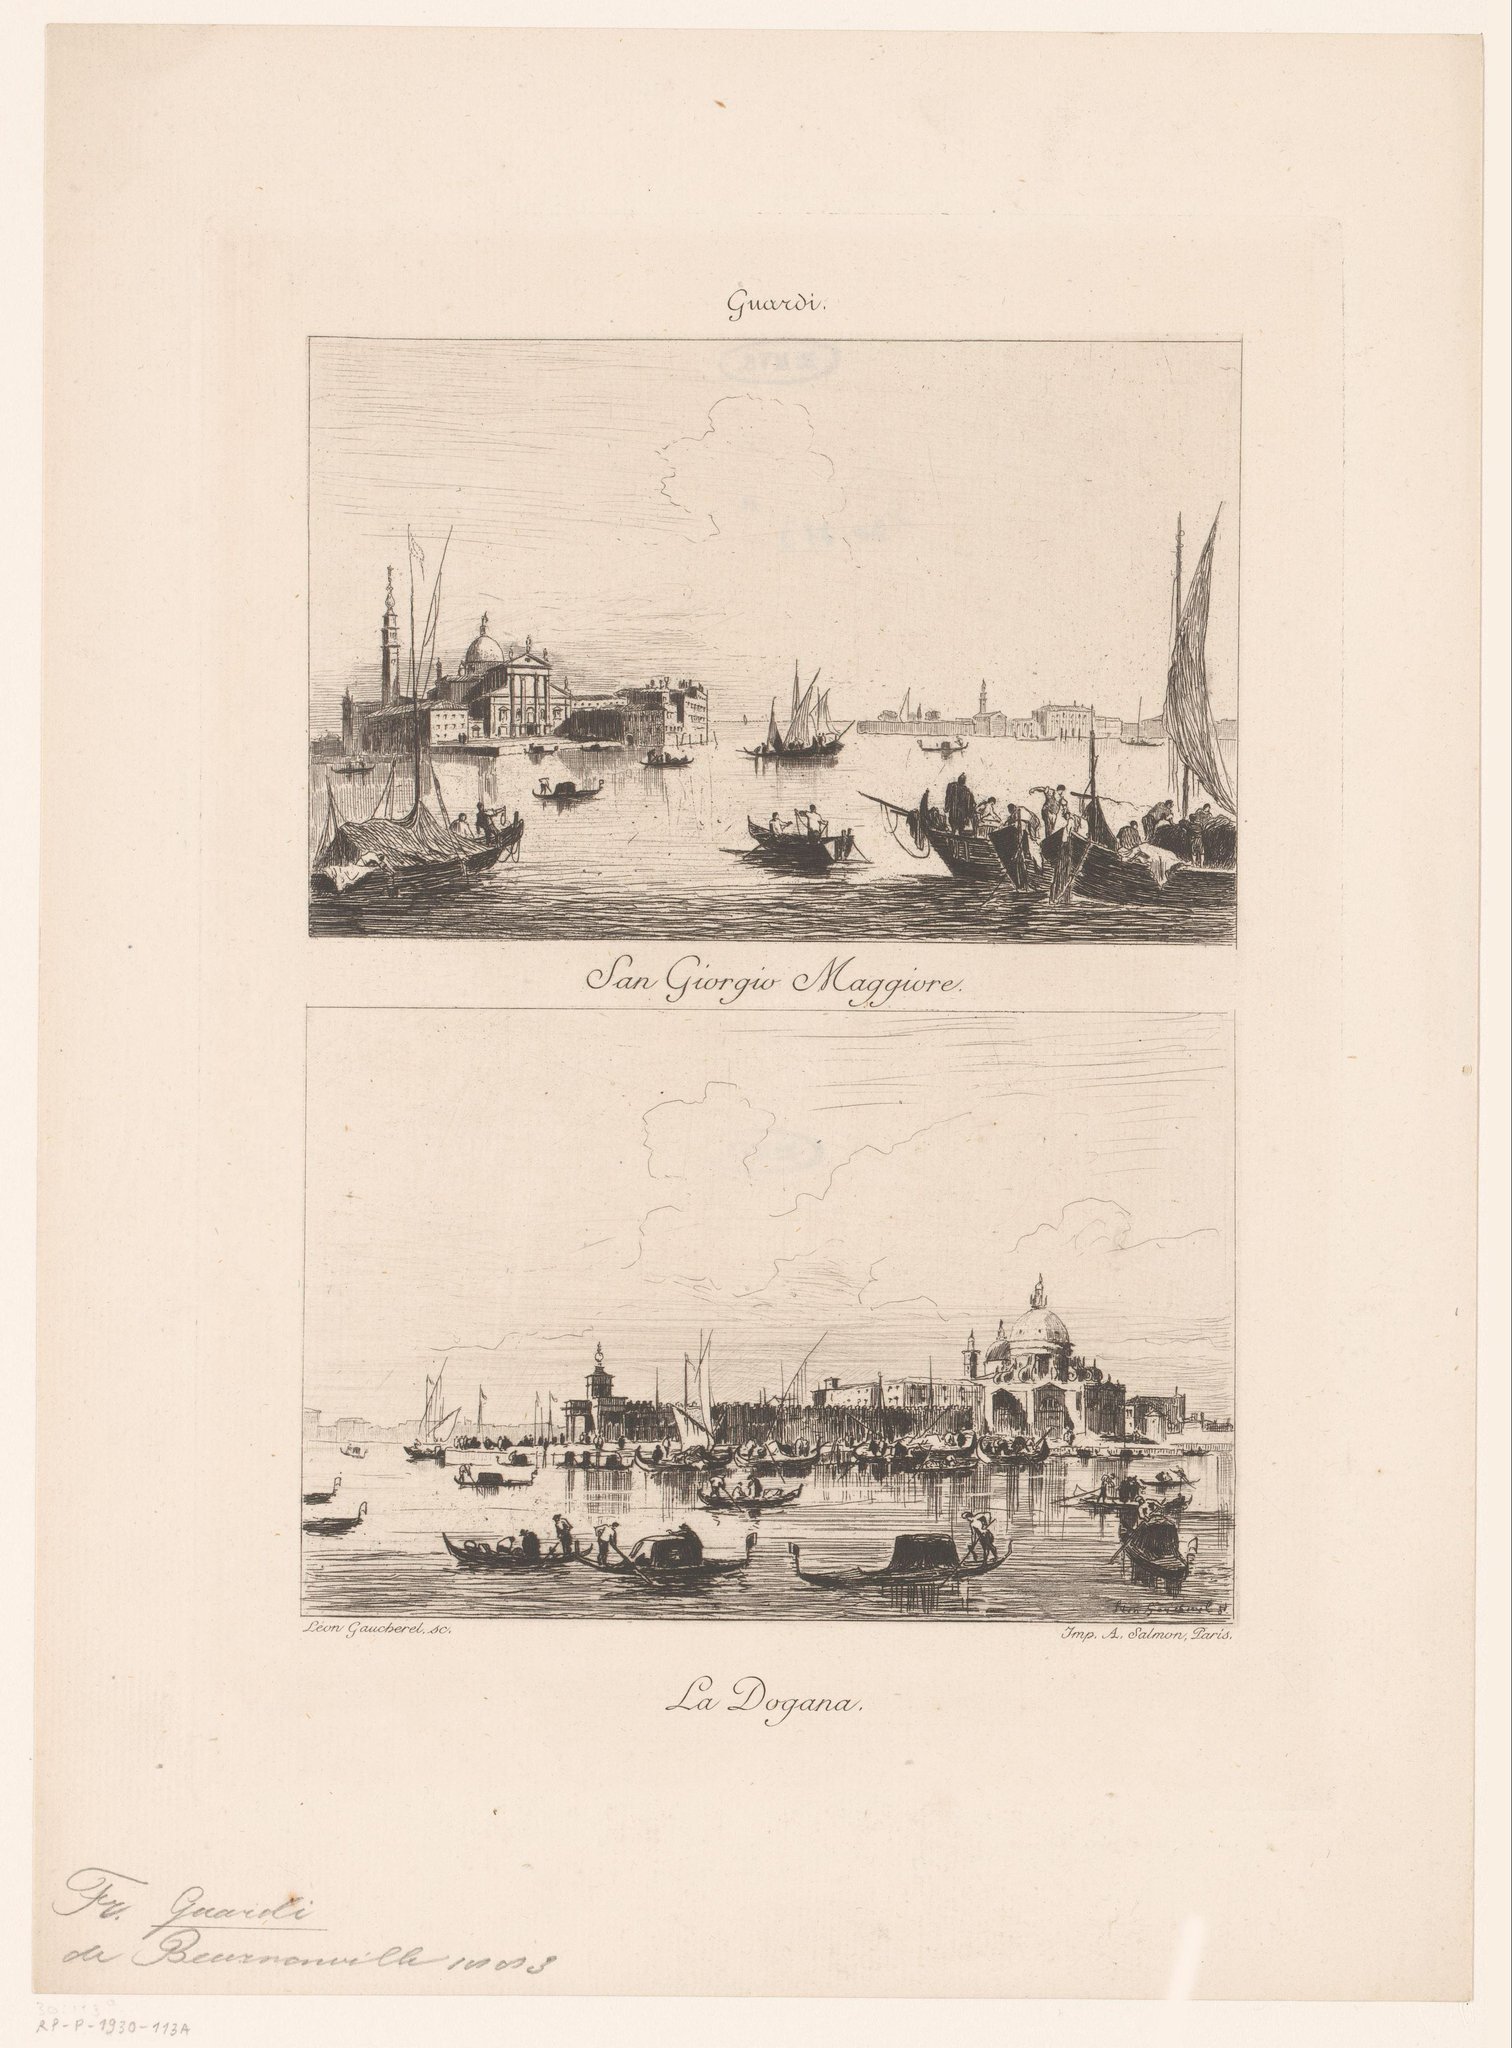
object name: print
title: Zicht op de San Giorgio Maggiore en het Dogepaleis in Venetië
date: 1835-1886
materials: paper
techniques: drypoint, engraving, etching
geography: france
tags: church (exterior), haff, lagoon created by sand, shingle bank ~ coast, gondola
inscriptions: collector's mark: Lugt 2228